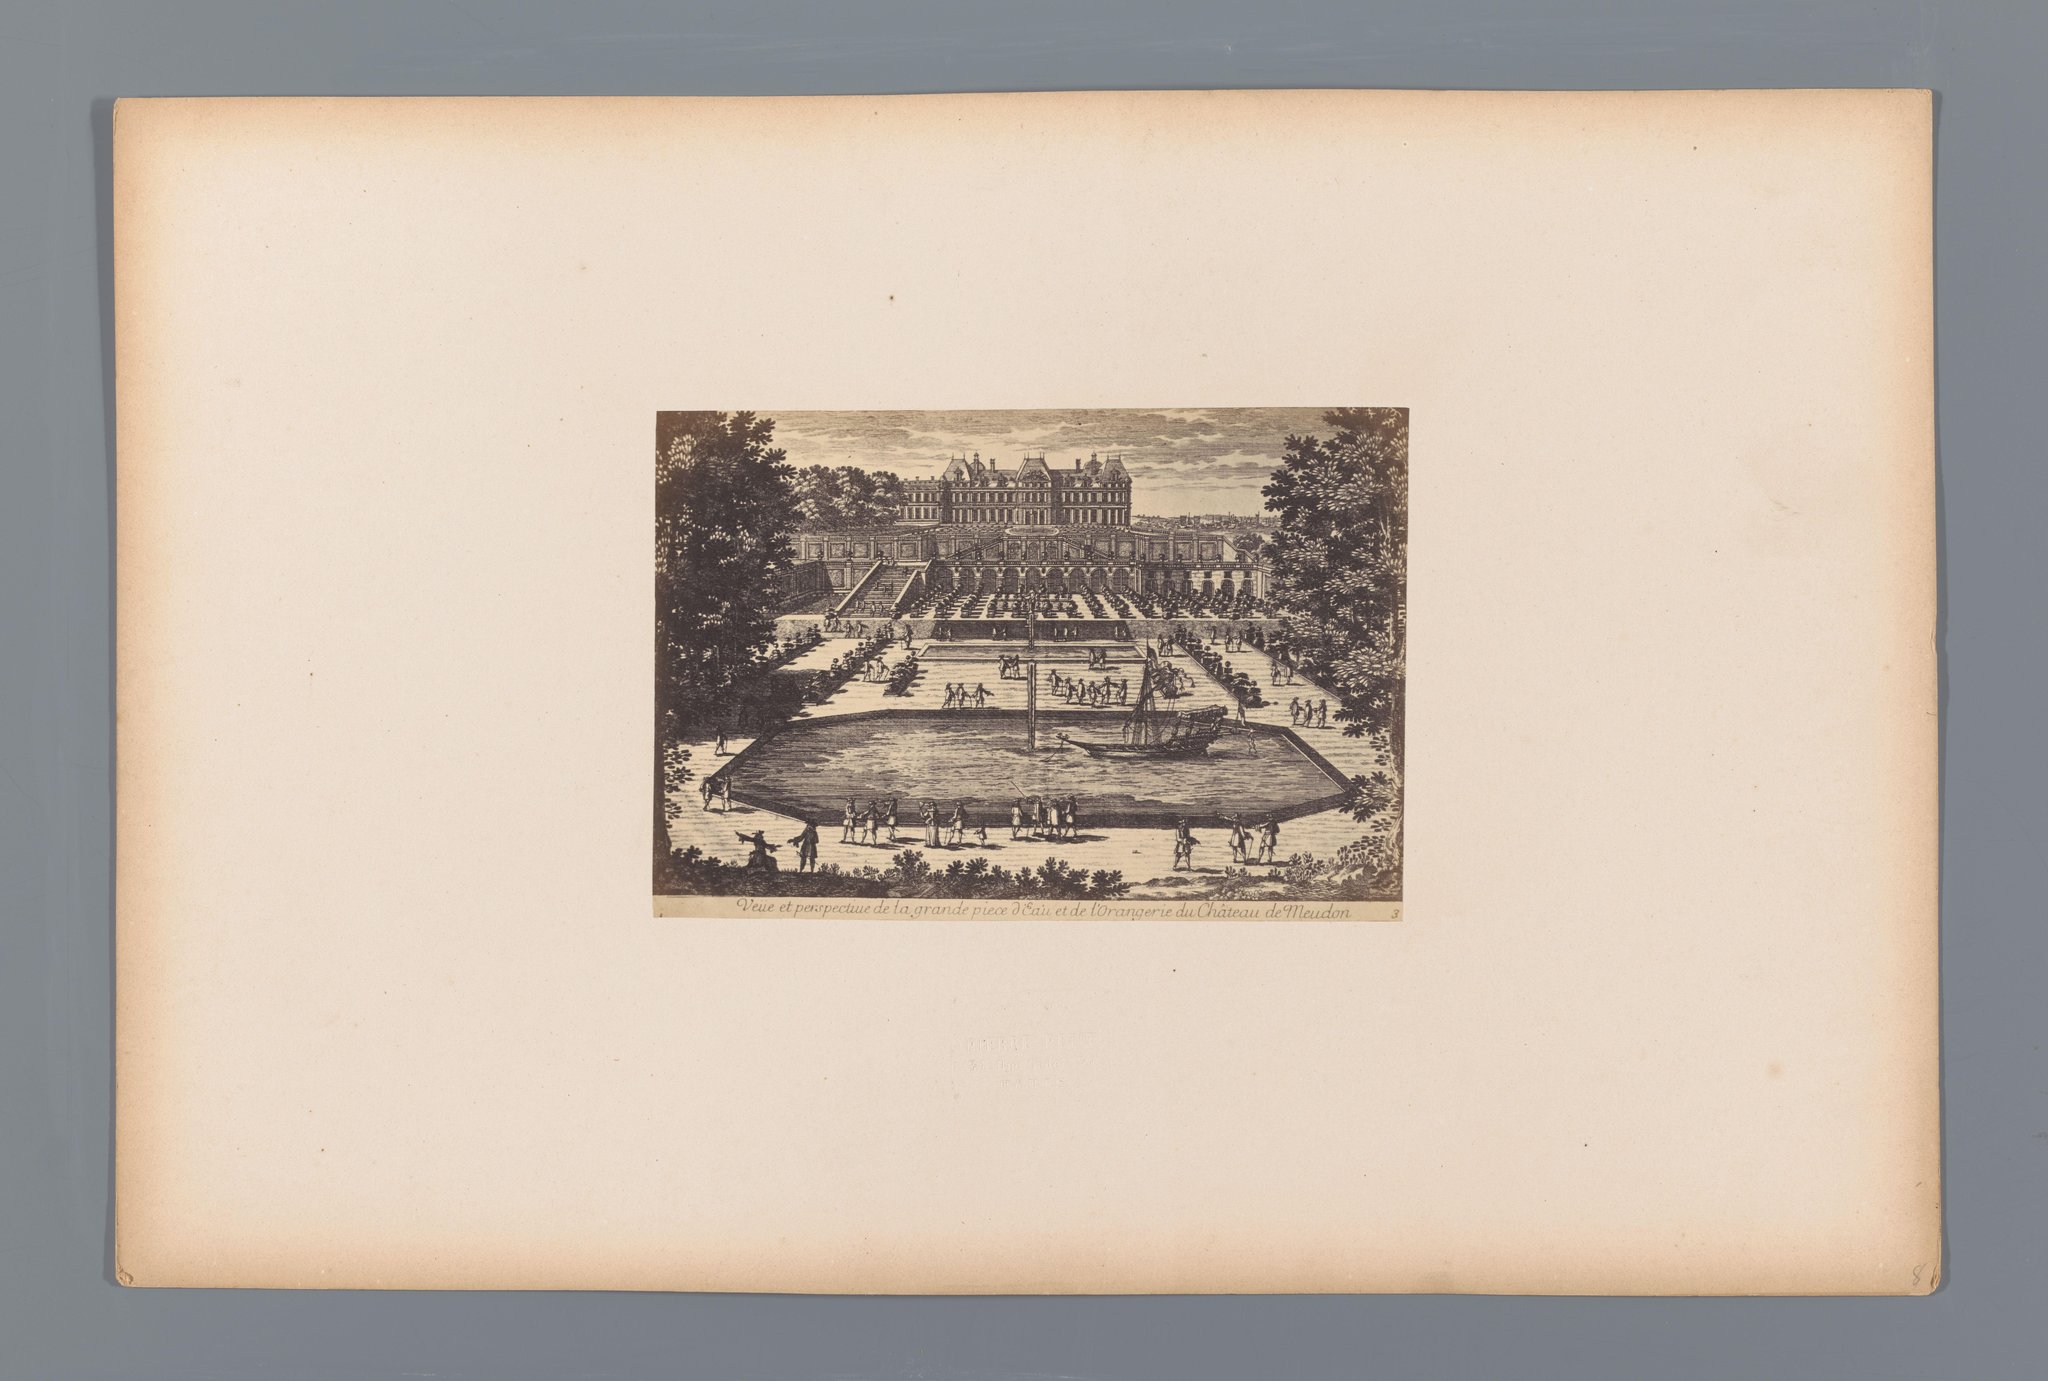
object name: photograph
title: Fotoreproductie van een ontwerp van een gezicht op het kasteel van Meudon, met op de voorgrond een waterpartij en oranjerie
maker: pierre petit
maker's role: fotograaf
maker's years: 1832-1909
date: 1860-1865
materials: photographic support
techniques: albumen print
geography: paris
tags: castle, greenhouse, orangery, garden pond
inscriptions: number: ‘8’, check stamp: ‘PHOTOGRAPHIE des DEUX MONDES/ PIERRE PETIT/ 31, Rue Cadet, 31/ PARIS’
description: Deze foto maakt deel uit van een omslag met 38 foto's en 17 tekstbladen.